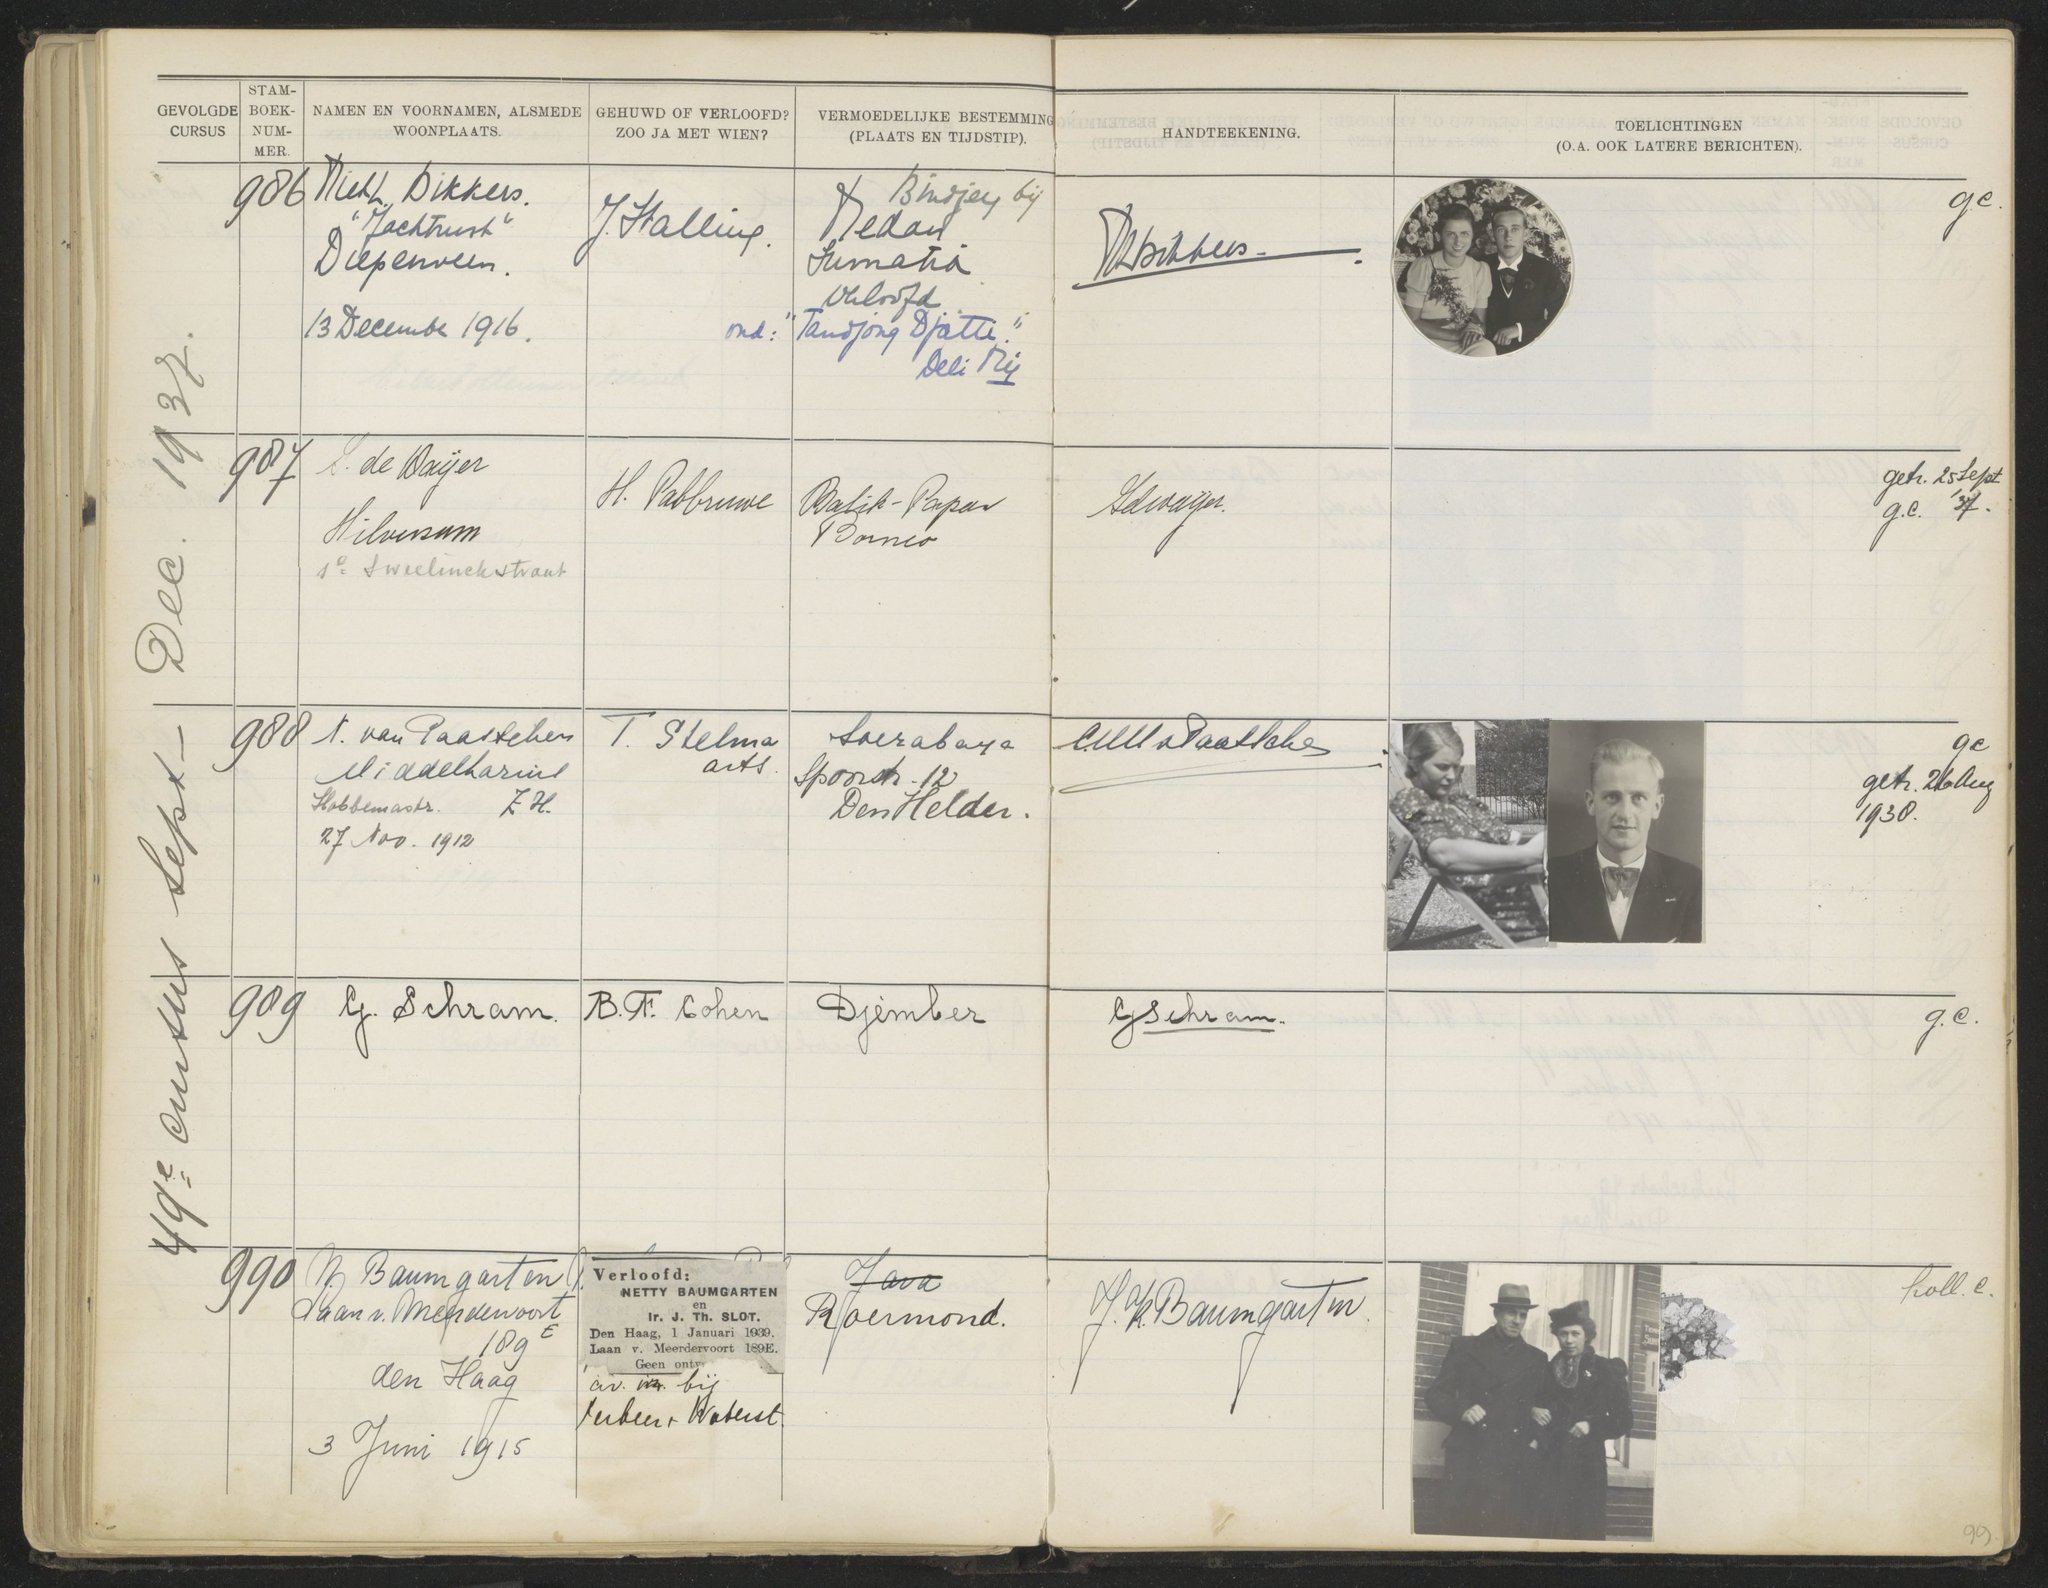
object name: photograph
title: Blad 99 uit Stamboek van de leerlingen der Koloniale School voor Meisjes en Vrouwen te 's-Gravenhage deel II (1930-1949)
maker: Anonymous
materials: paper, photographic support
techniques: photography, printing, writing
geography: the hague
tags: further education (+ pupil), further education, the hague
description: Twee pagina's met gegevens van de deelnemers aan de 49e driemaandelijkse cursus van september tot december 1937, stamboeknummers 986 tot en met 990. Onderdeel van Stamboek van de leerlingen der Koloniale School voor Meisjes en Vrouwen te 's-Gravenhage deel II (1930-1949).